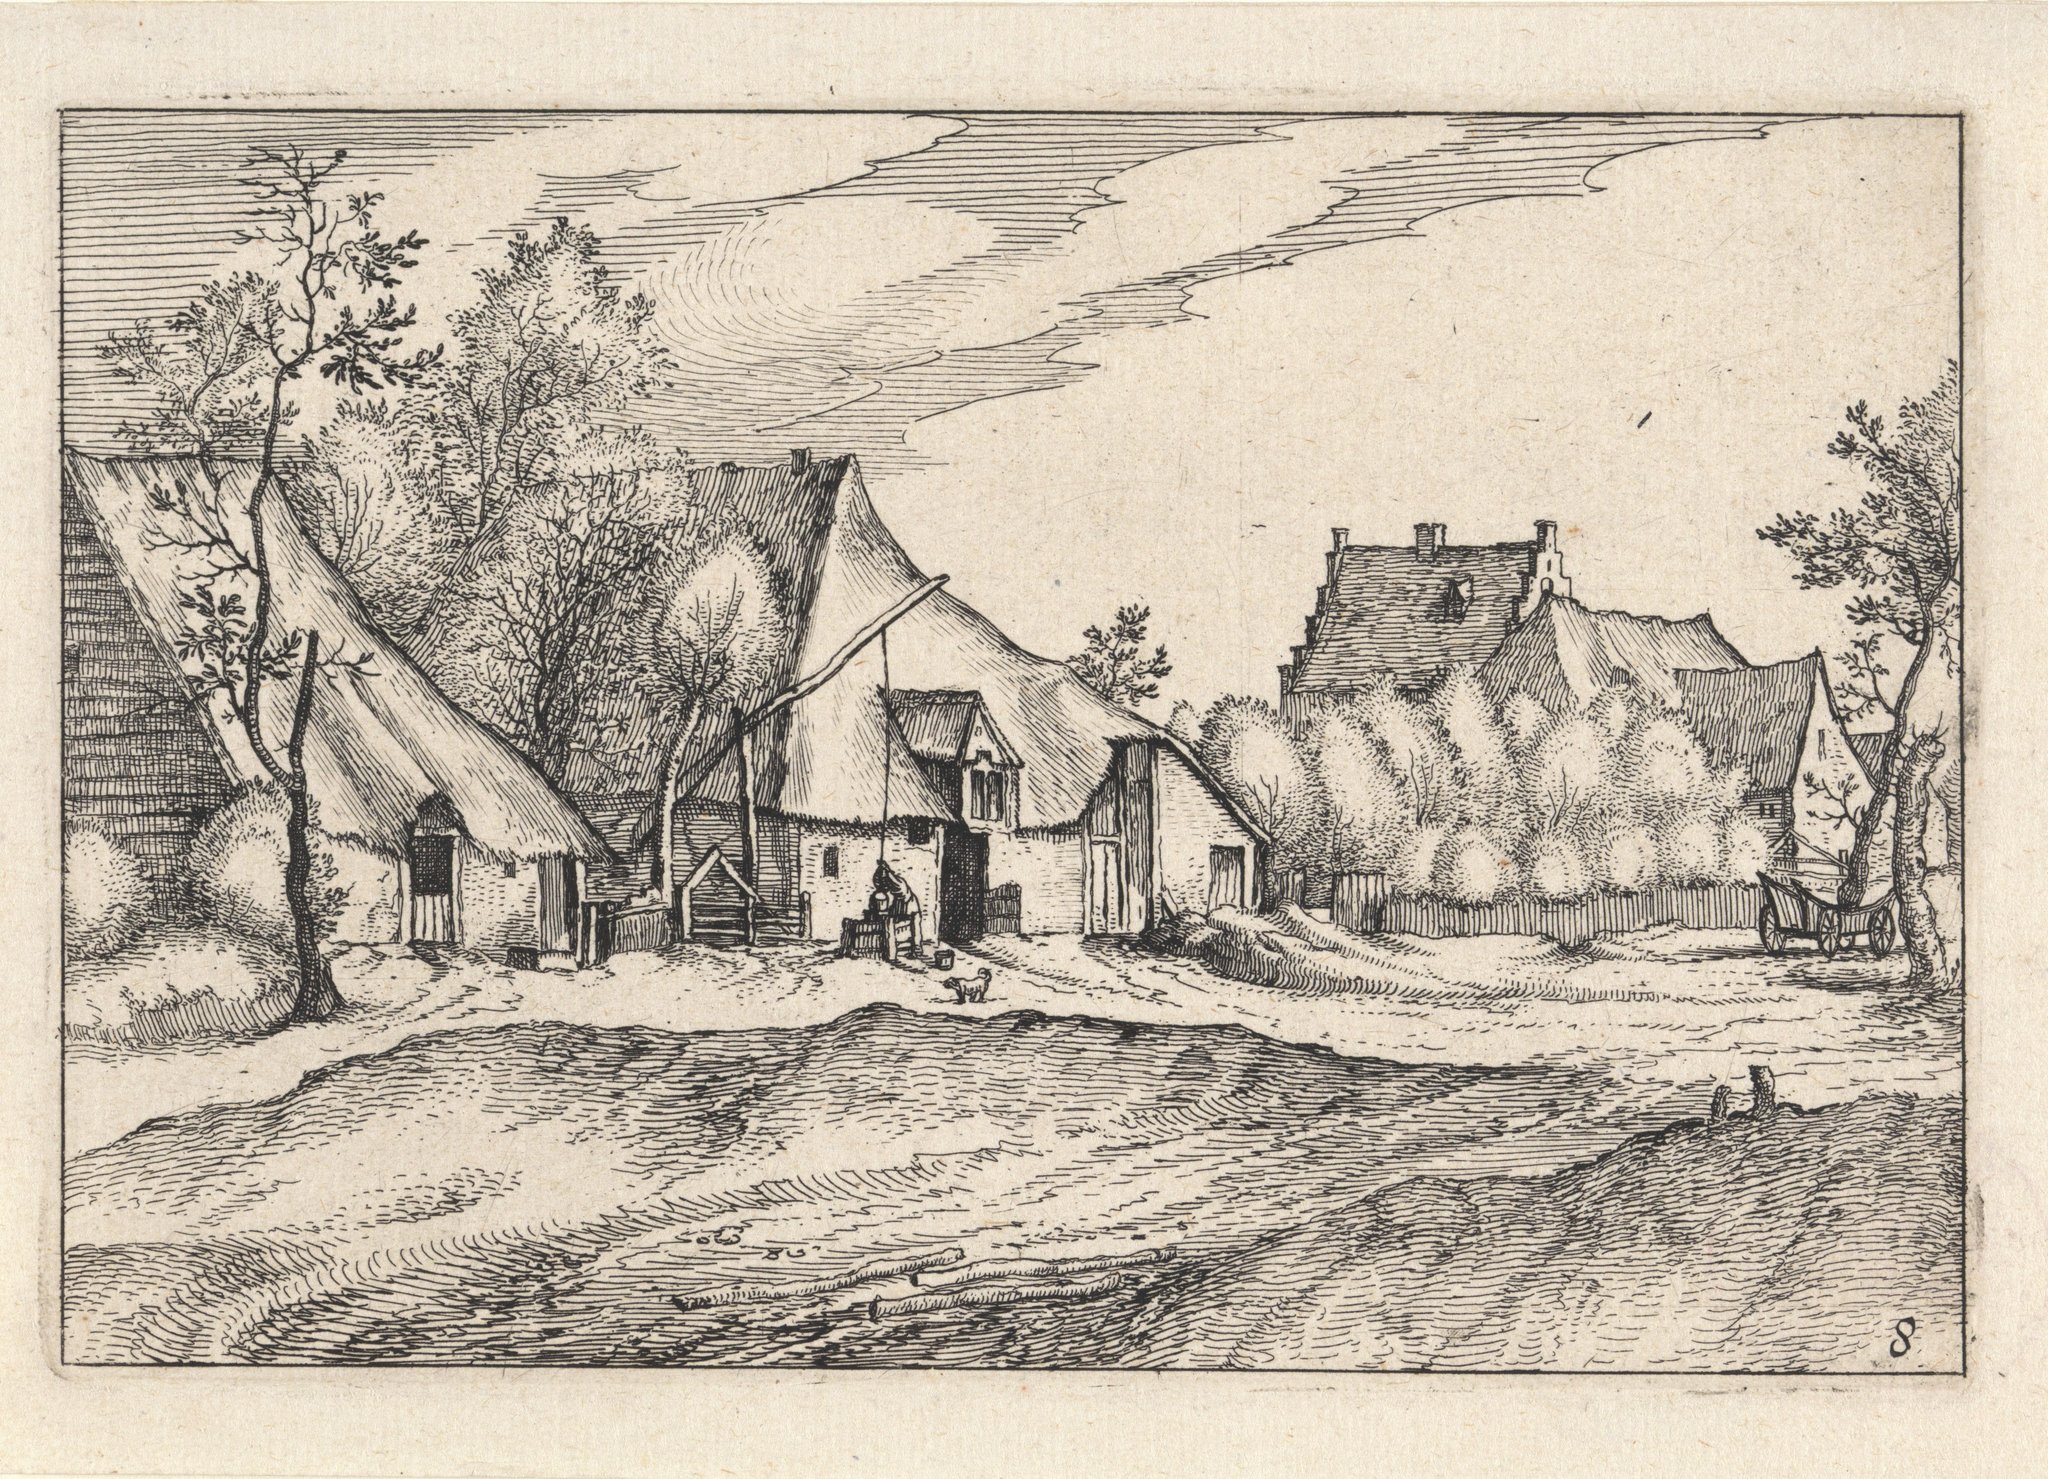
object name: print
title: Boerderijen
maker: claes jansz. visscher (ii)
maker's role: draughtsman, print maker, publisher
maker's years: 1586-1652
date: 1612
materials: paper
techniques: etching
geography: amsterdam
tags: farm or solitary house in landscape, dog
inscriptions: collector's mark: Lugt 240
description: Gezicht op een landweg met links een rij boerderijen en op de achtergrond een stenen huis met een trapgevel. Links haalt een figuur water uit een put.